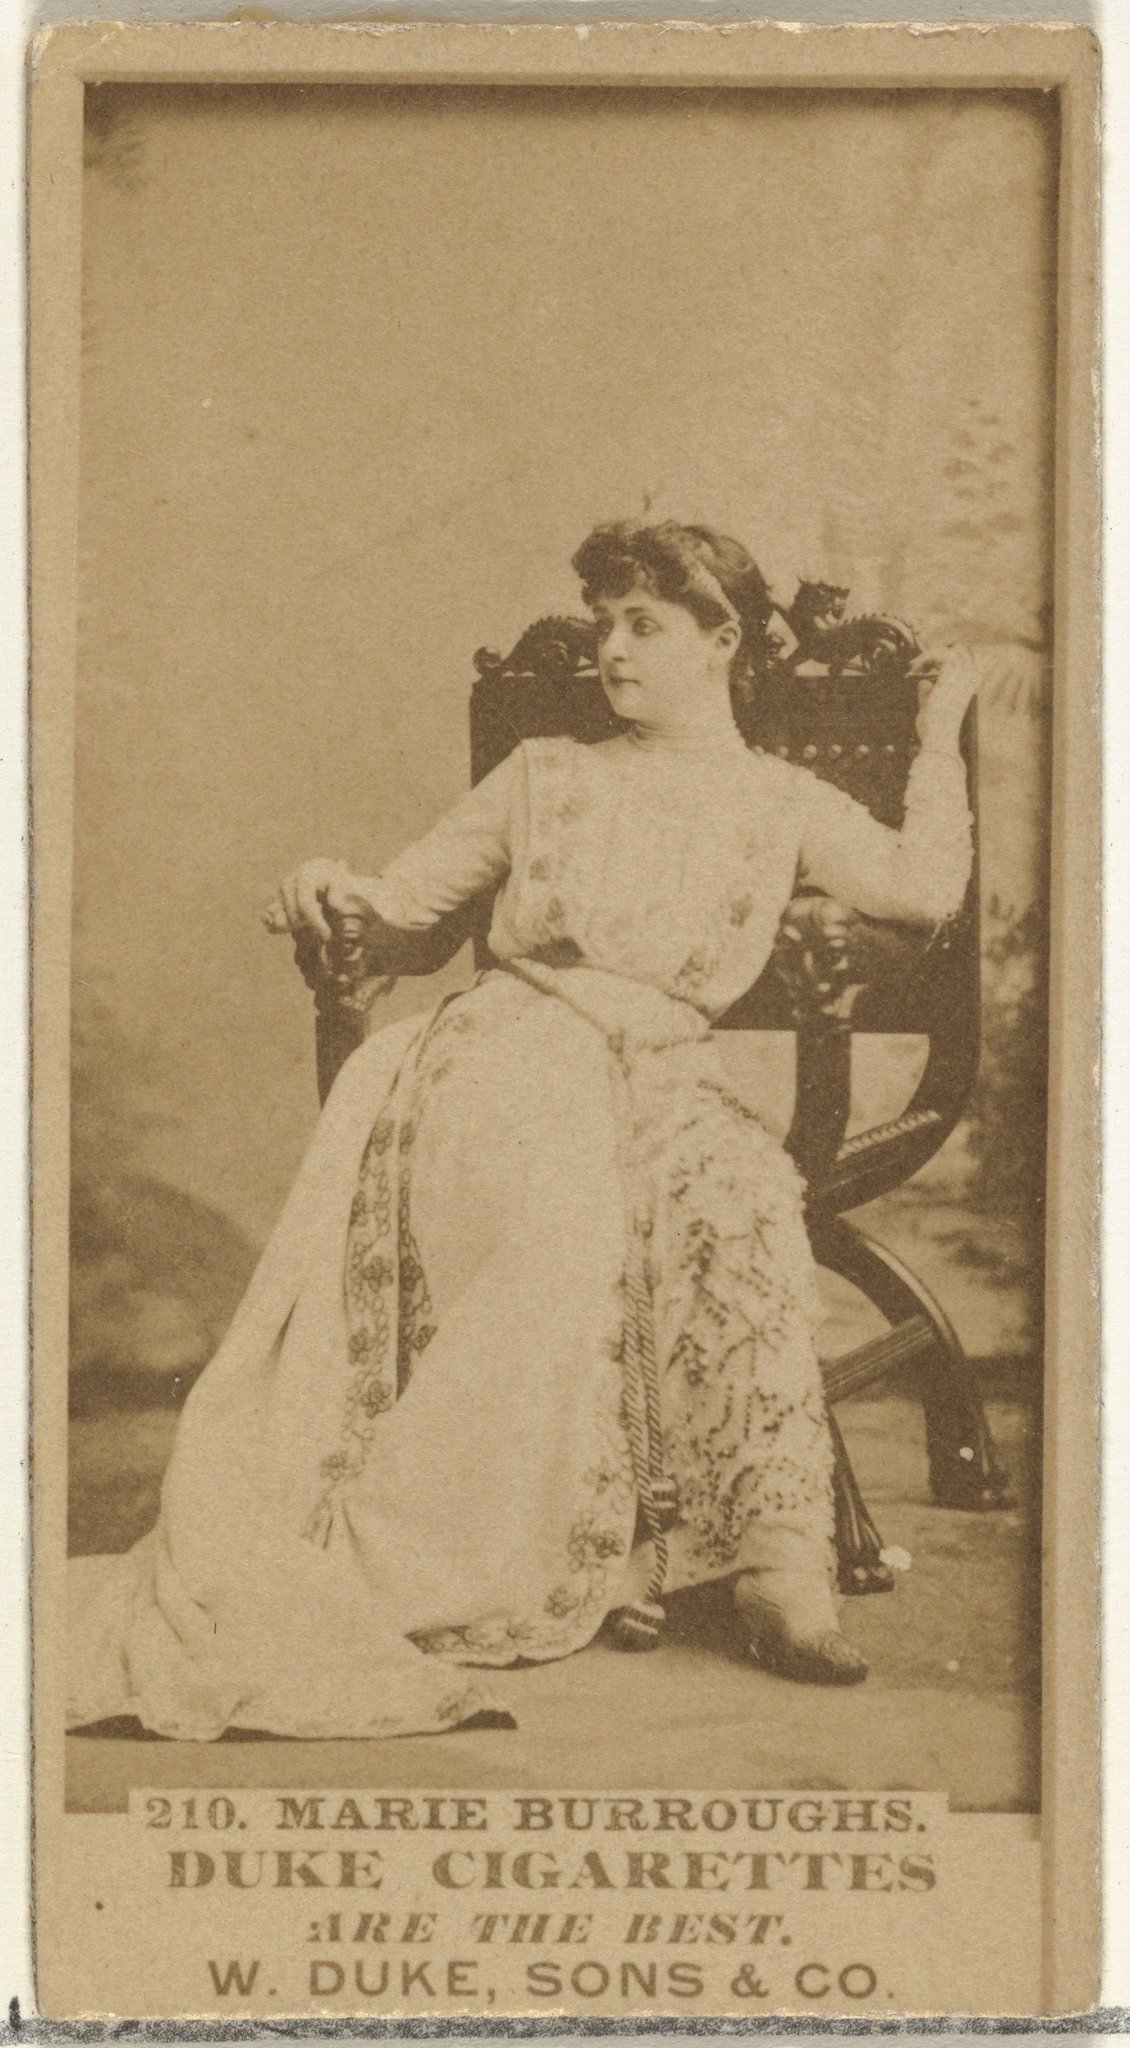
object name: photograph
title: Card Number 210, Marie Burroughs, from the Actors and Actresses series (N145-7) issued by Duke Sons & Co. to promote Duke Cigarettes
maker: w. duke, sons & co.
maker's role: publisher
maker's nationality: american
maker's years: 1870-1920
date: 1880-1889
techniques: albumen silver print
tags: portraits,women,actresses